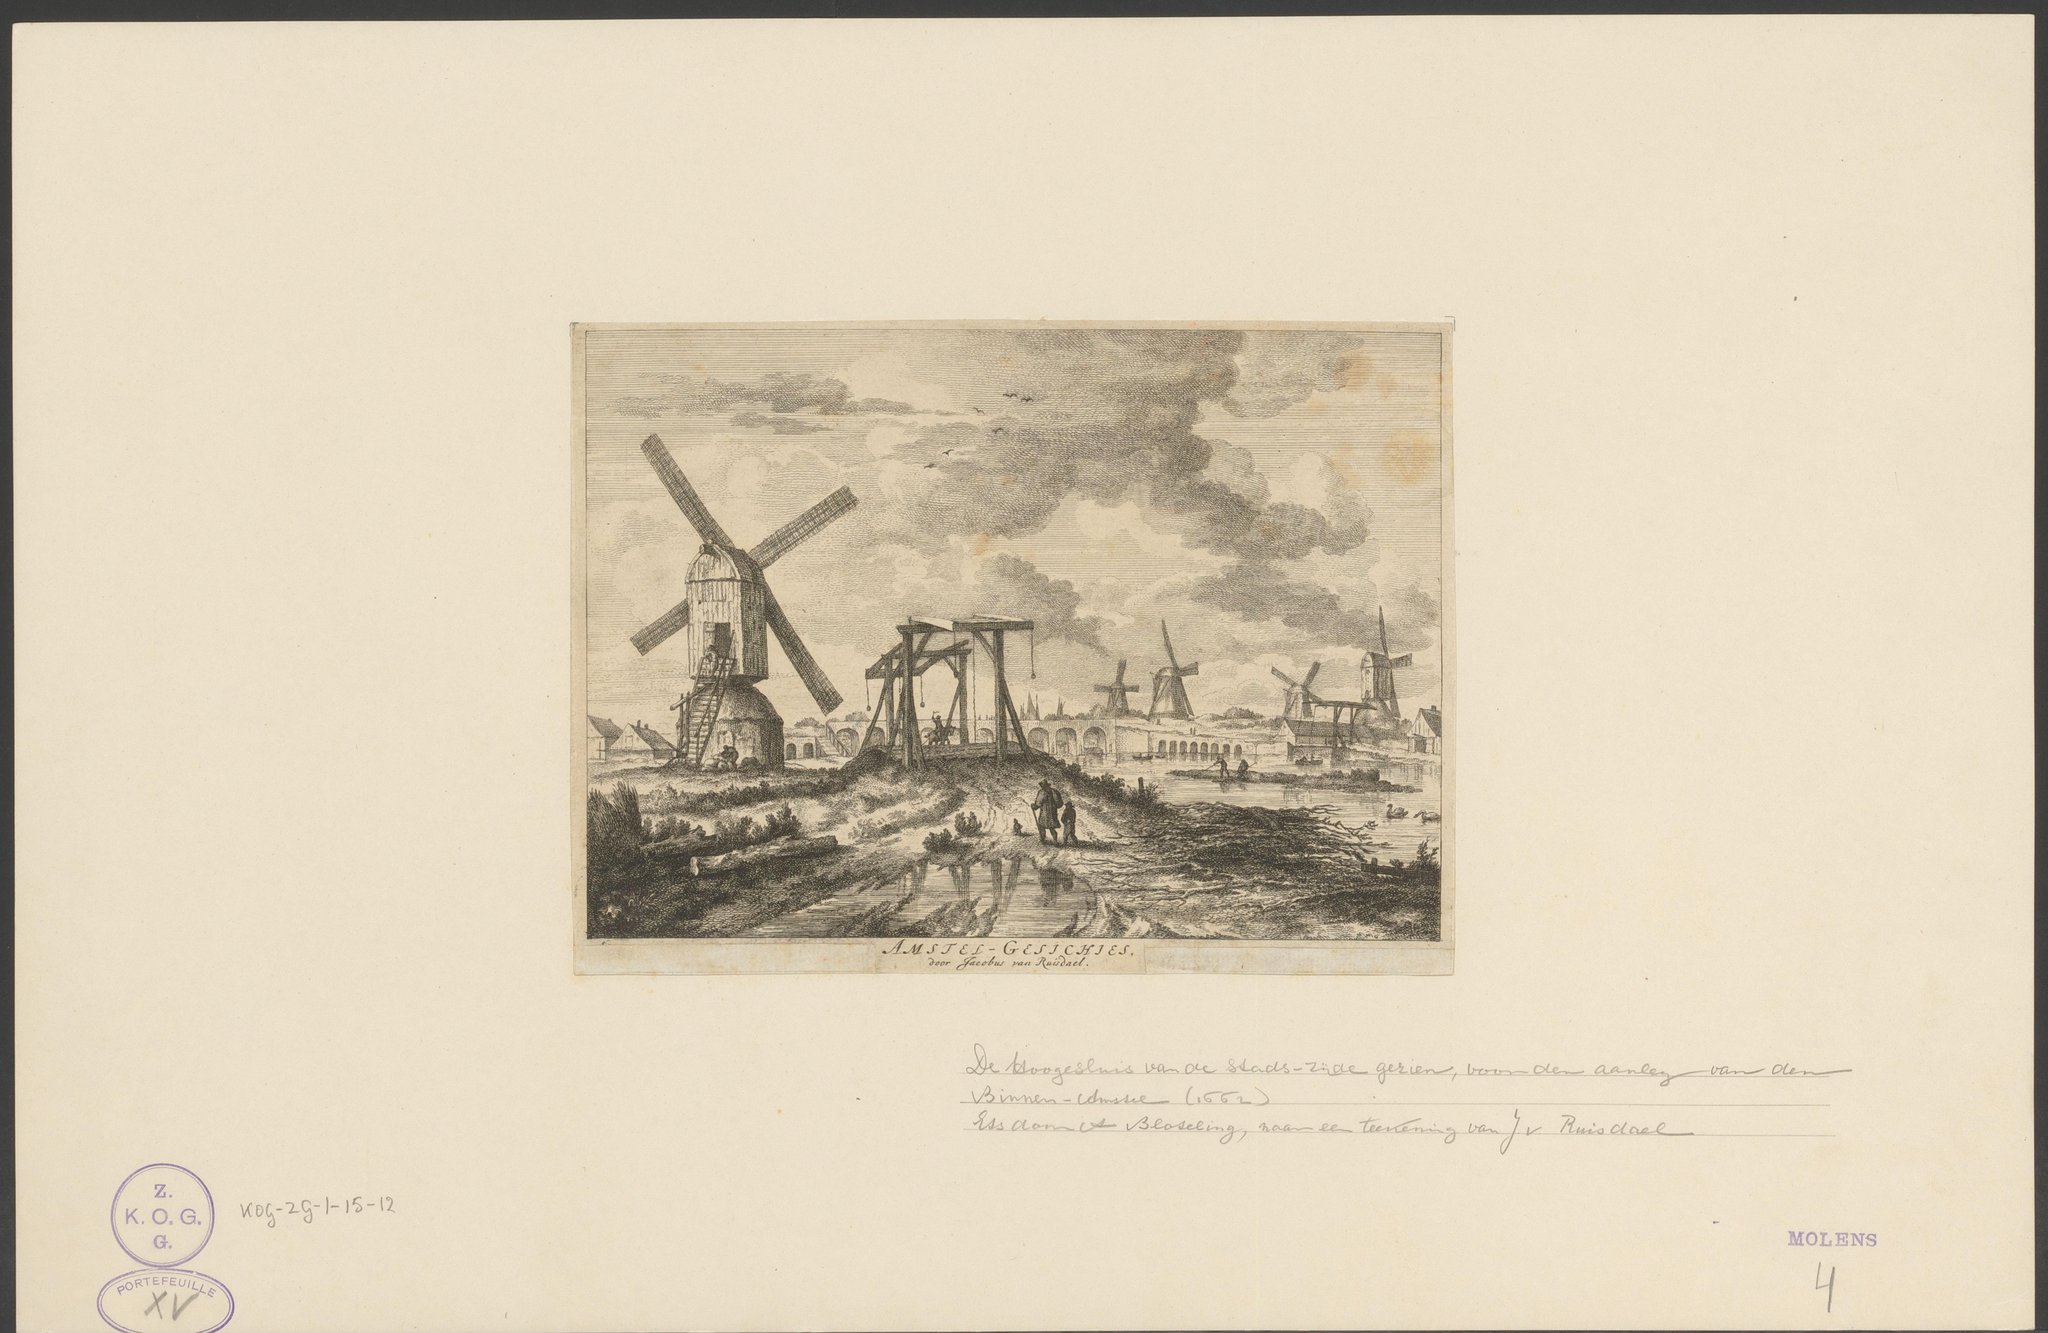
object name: print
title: Amstel-Gesichies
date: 1664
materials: paper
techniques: etching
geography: amsterdam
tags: canals, waters (in city), bridge in city across river, canal, etc., windmill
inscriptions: collector's mark: Lugt 1641, stamp, stamp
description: Onderwerpsrubrieken binnen de Atlas Zeden en Gewoonten: Handel, nijverheid en verkeer, Molens.